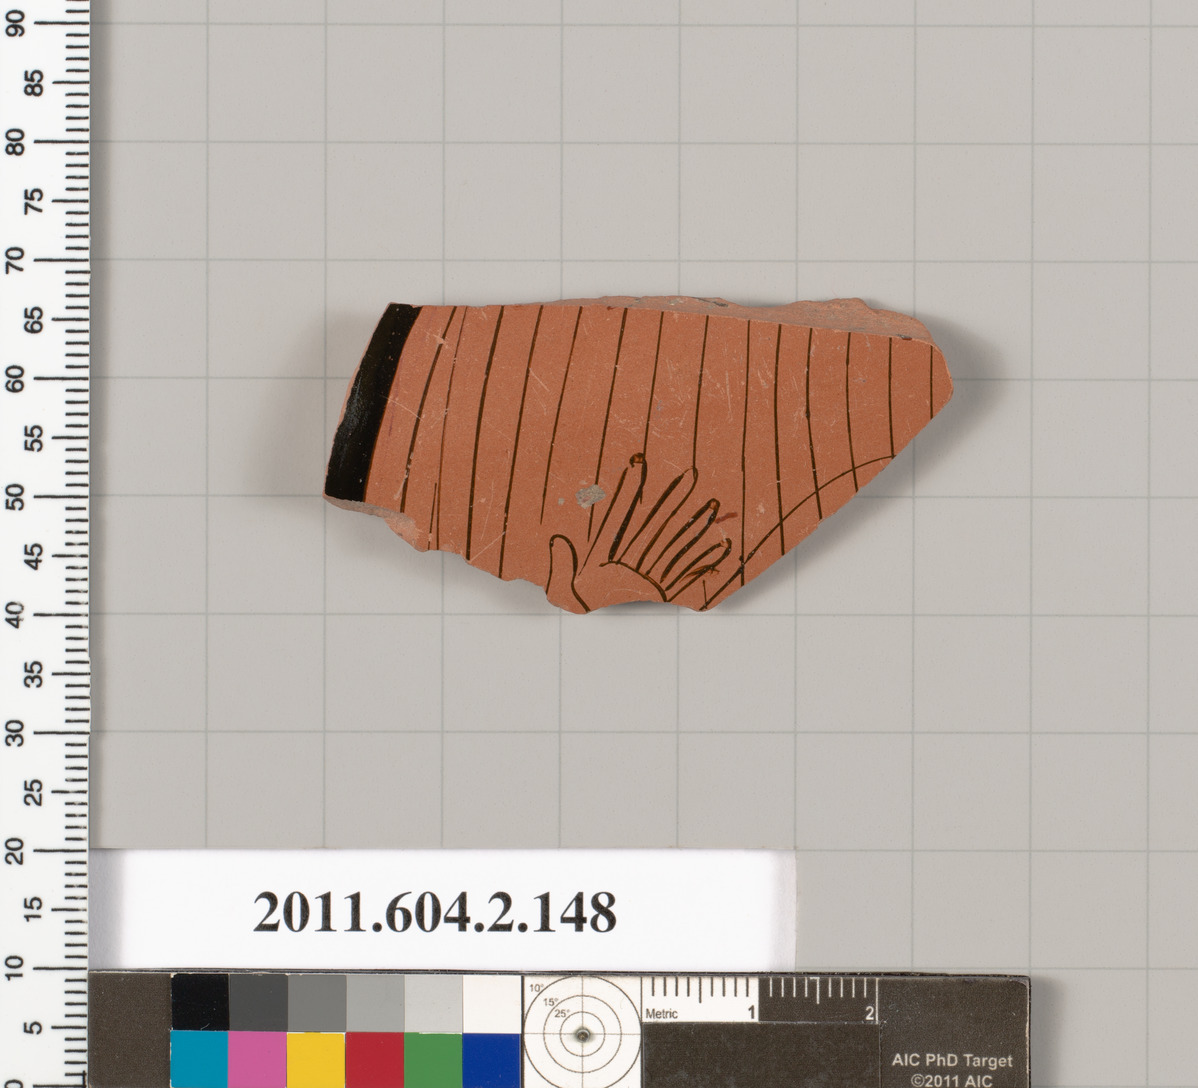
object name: stamnos fragment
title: Terracotta fragment of a stamnos (jar)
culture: greek, attic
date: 470-460 BCE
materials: terracotta